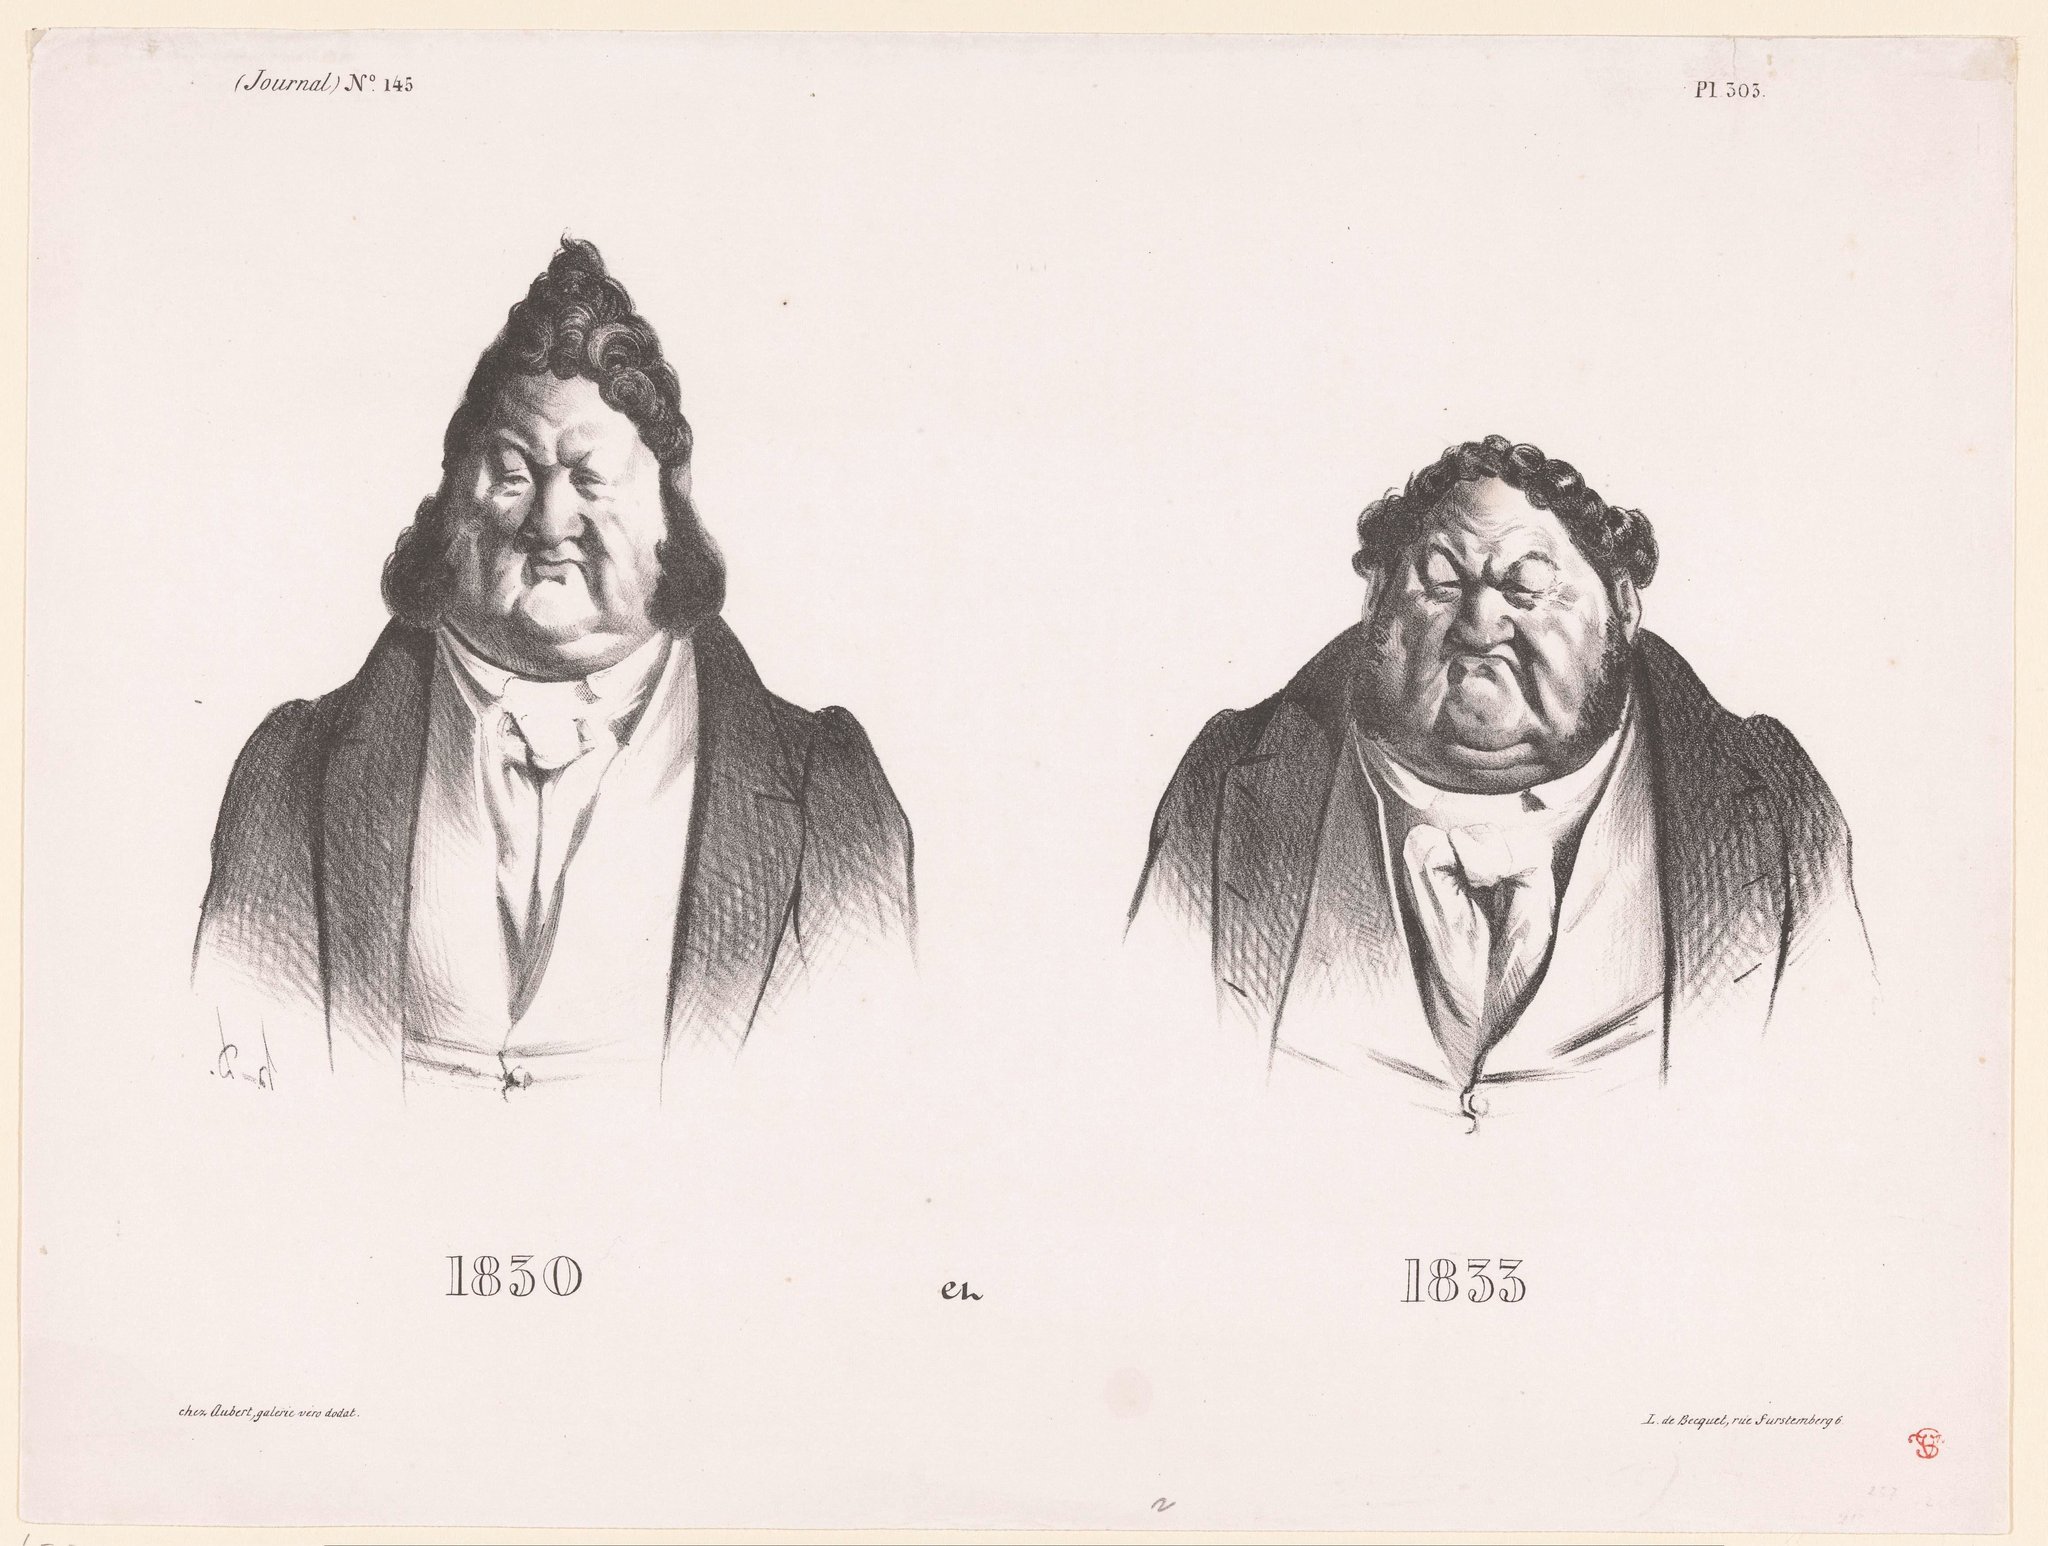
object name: print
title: 1830 et 1833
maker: honoré daumier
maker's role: draughtsman, painter, print maker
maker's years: 1808-1879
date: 1833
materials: paper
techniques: lithograph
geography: paris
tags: paris, lodewijk filips i (koning van frankrijk), caricatures (human types), historical persons, political caricatures and satires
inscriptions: collector's mark: Lugt 2228a, collector's mark: Lugt 2373c, collector's mark: Lugt 2760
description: Prent gepubliceerd in: La Caricature, 15 augustus 1833, nr. 145, pl. 303.